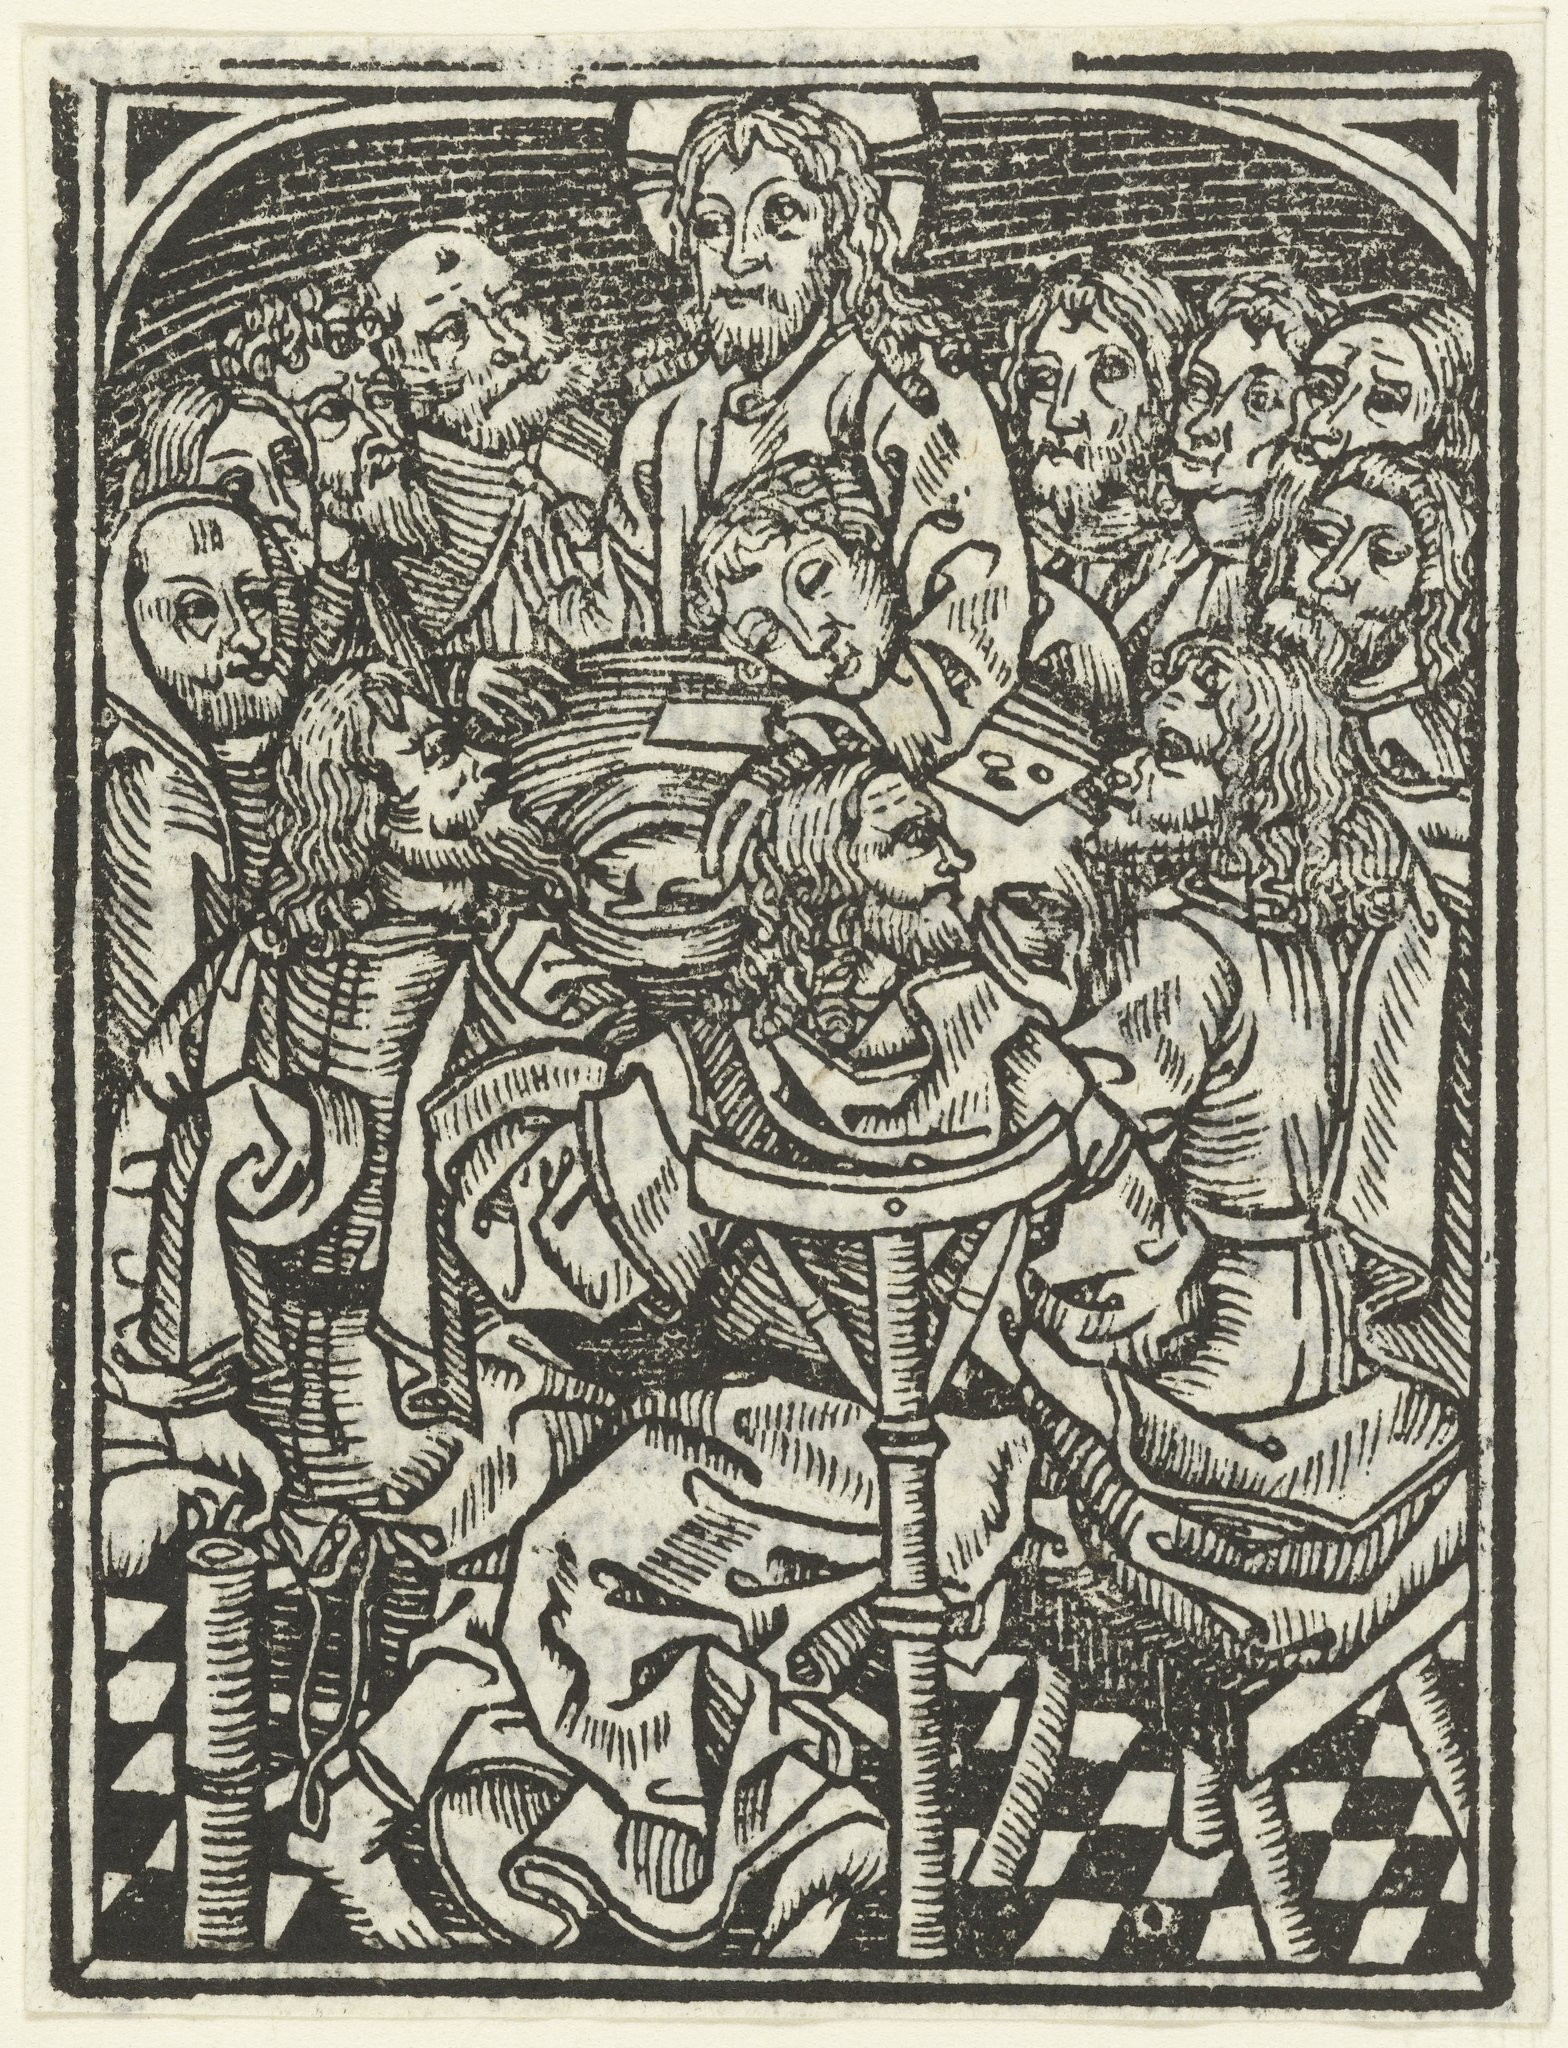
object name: book illustration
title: Het laatste avondmaal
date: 1490-1500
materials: paper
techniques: woodcut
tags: last supper (in general) (matthew 26:21-35; mark 14:18-31; luke 22:3, 22:15-23; john 13:21-38)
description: Eén blad van 113 uit Ludolphus de Saxonia, "Dit es dleué ons liefs heeren ihesu christi". Anonieme Nederlandse vertaling. Uitgegeven door Henrick Eckert van Homberch te Antwerpen in 1503. Botke, K. Deze 113 houtsneden, die meestal reeds in vroege Nederlandse boeken gebruikt zijn, worden toegeschreven aan de tweede Meester van Delft, de Meester van de Delbecq-Schreiber-passie en de Meester van de Virgo inter Virgines. In Conway (1884) en in "De gulden passer"(1951) zijn ook eerdere versies opgenomen. Botke, K.